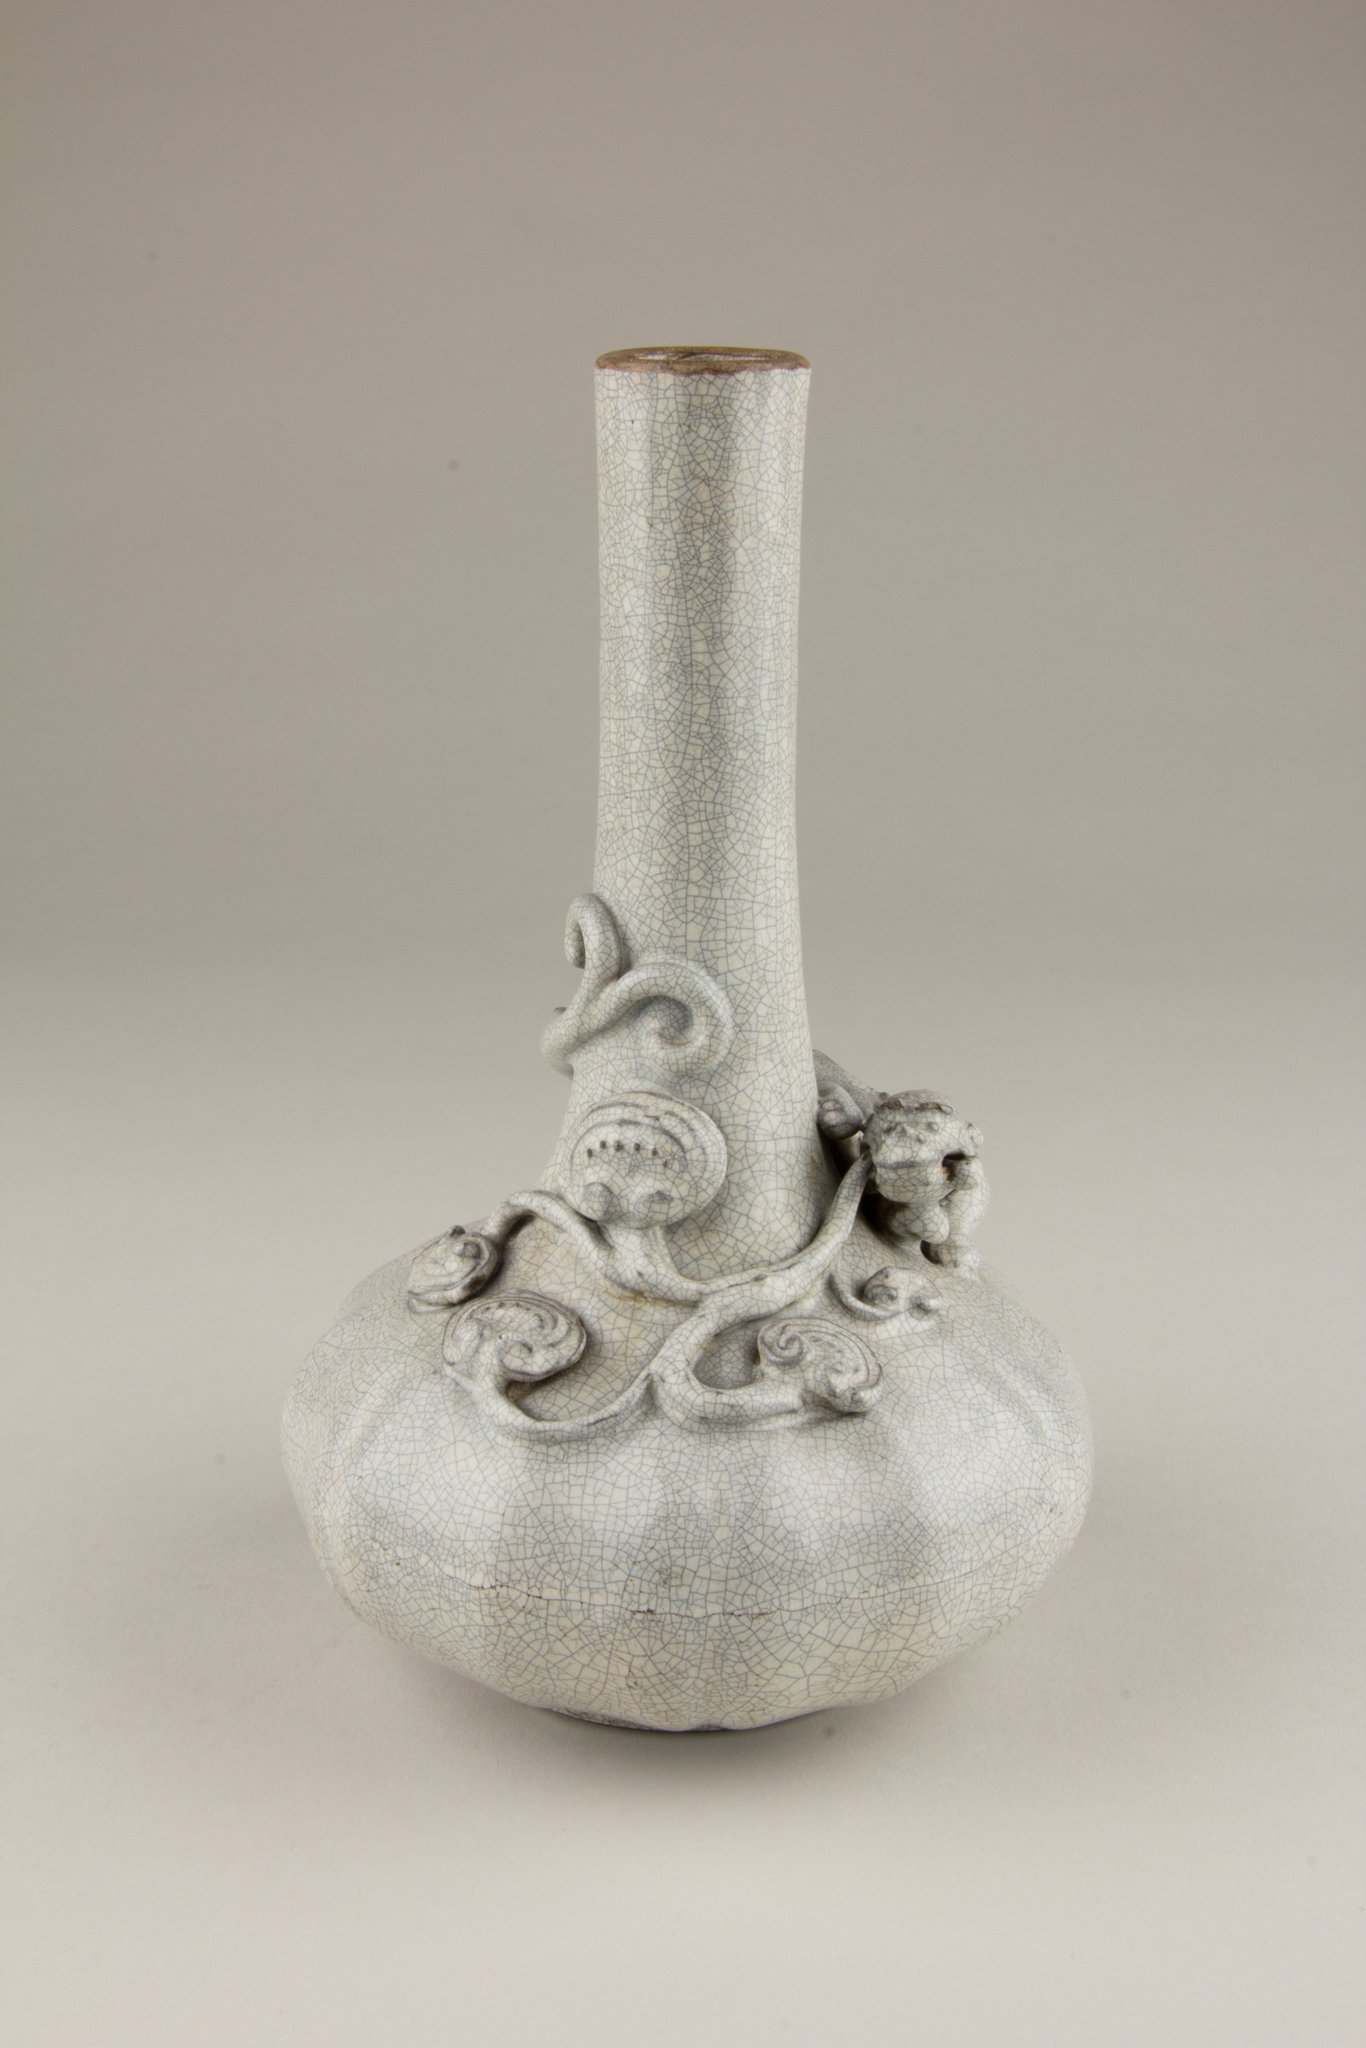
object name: vase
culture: chinese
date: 1368-1644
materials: pottery